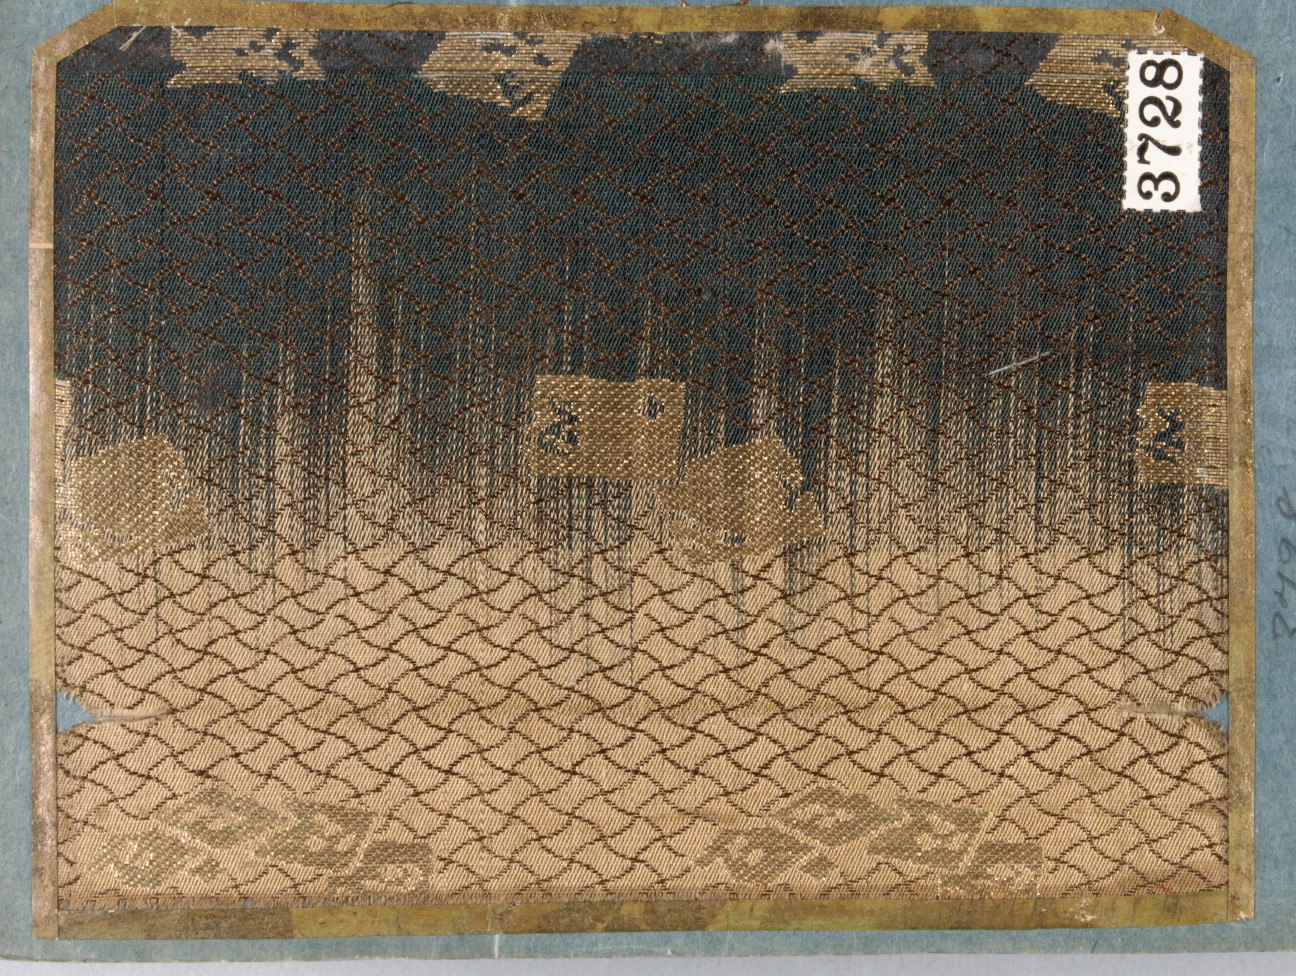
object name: sample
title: Textile Sample from Sample Book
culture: japanese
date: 1801-1900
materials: silk